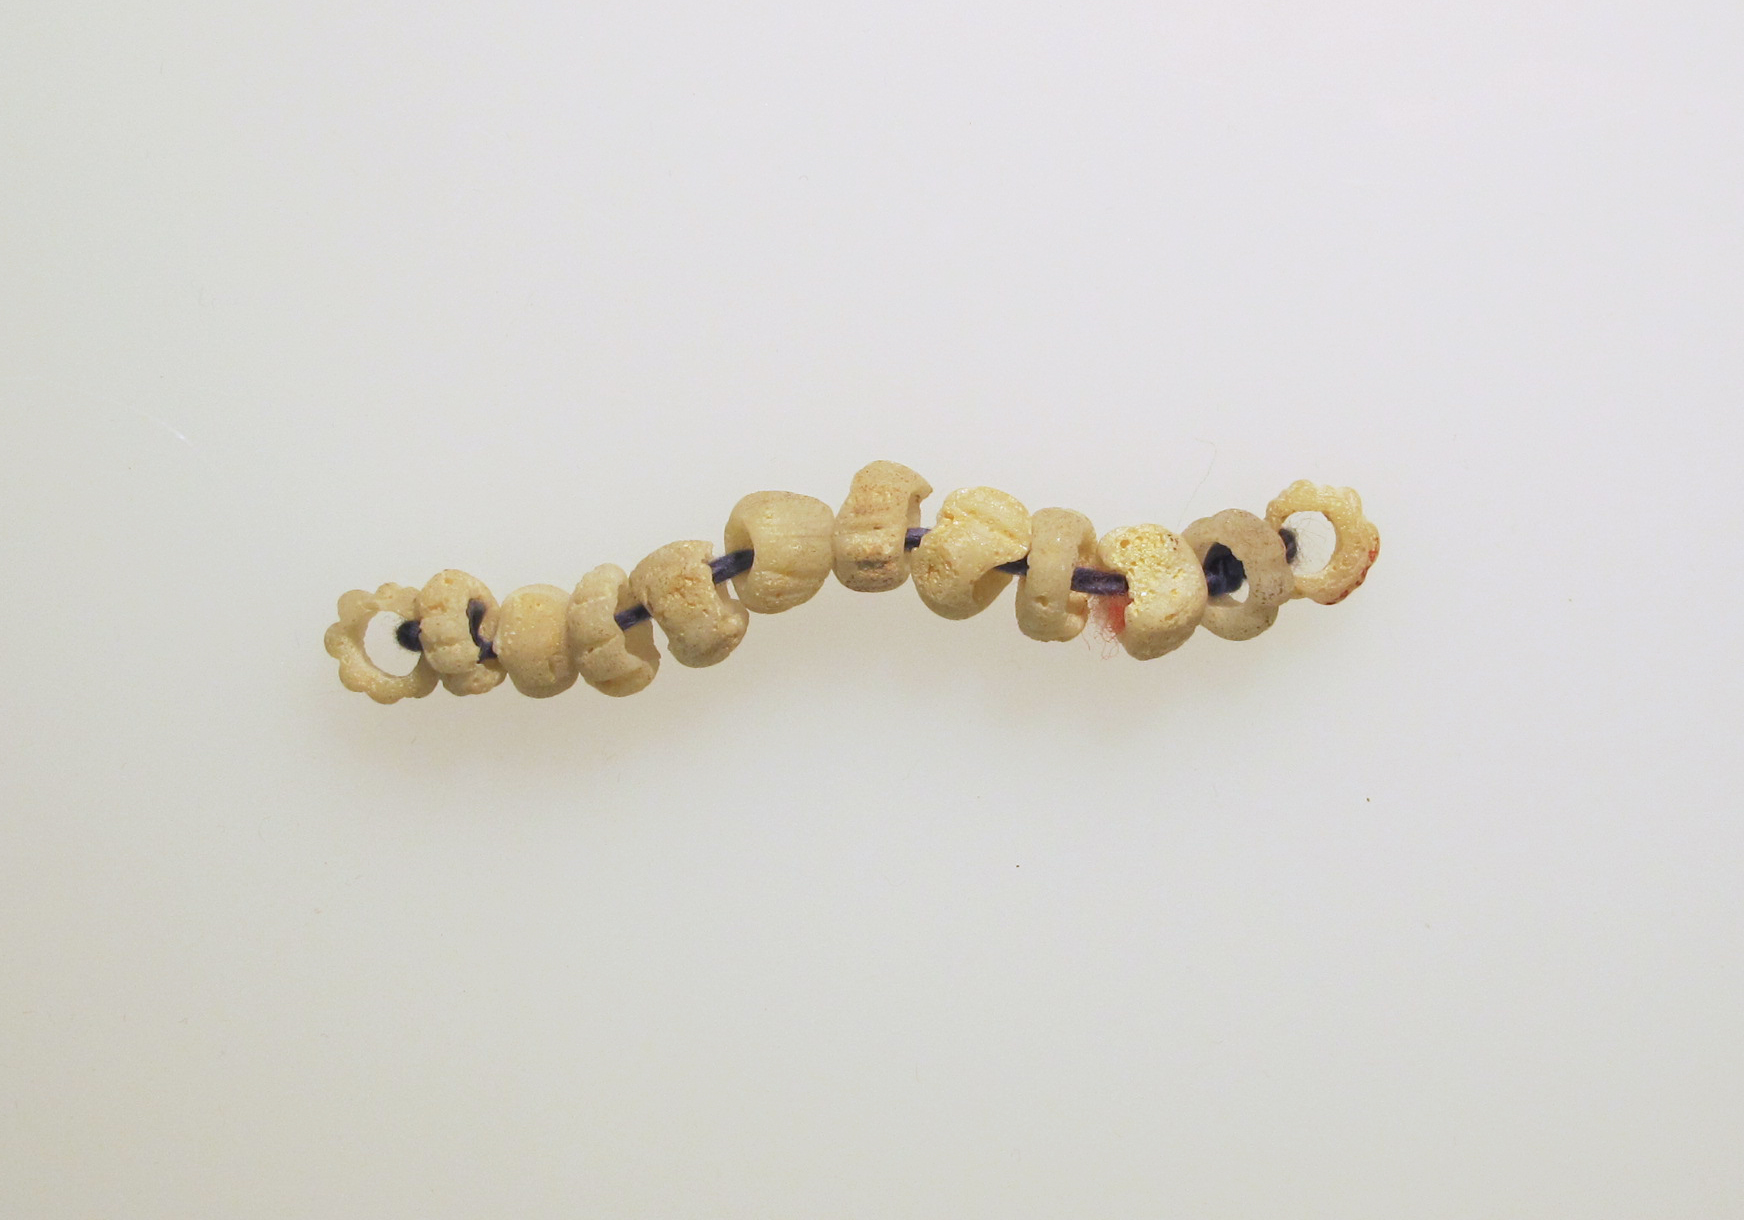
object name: bead, twelve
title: Beads, 12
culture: roman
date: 670 BCE-330 CE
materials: glass